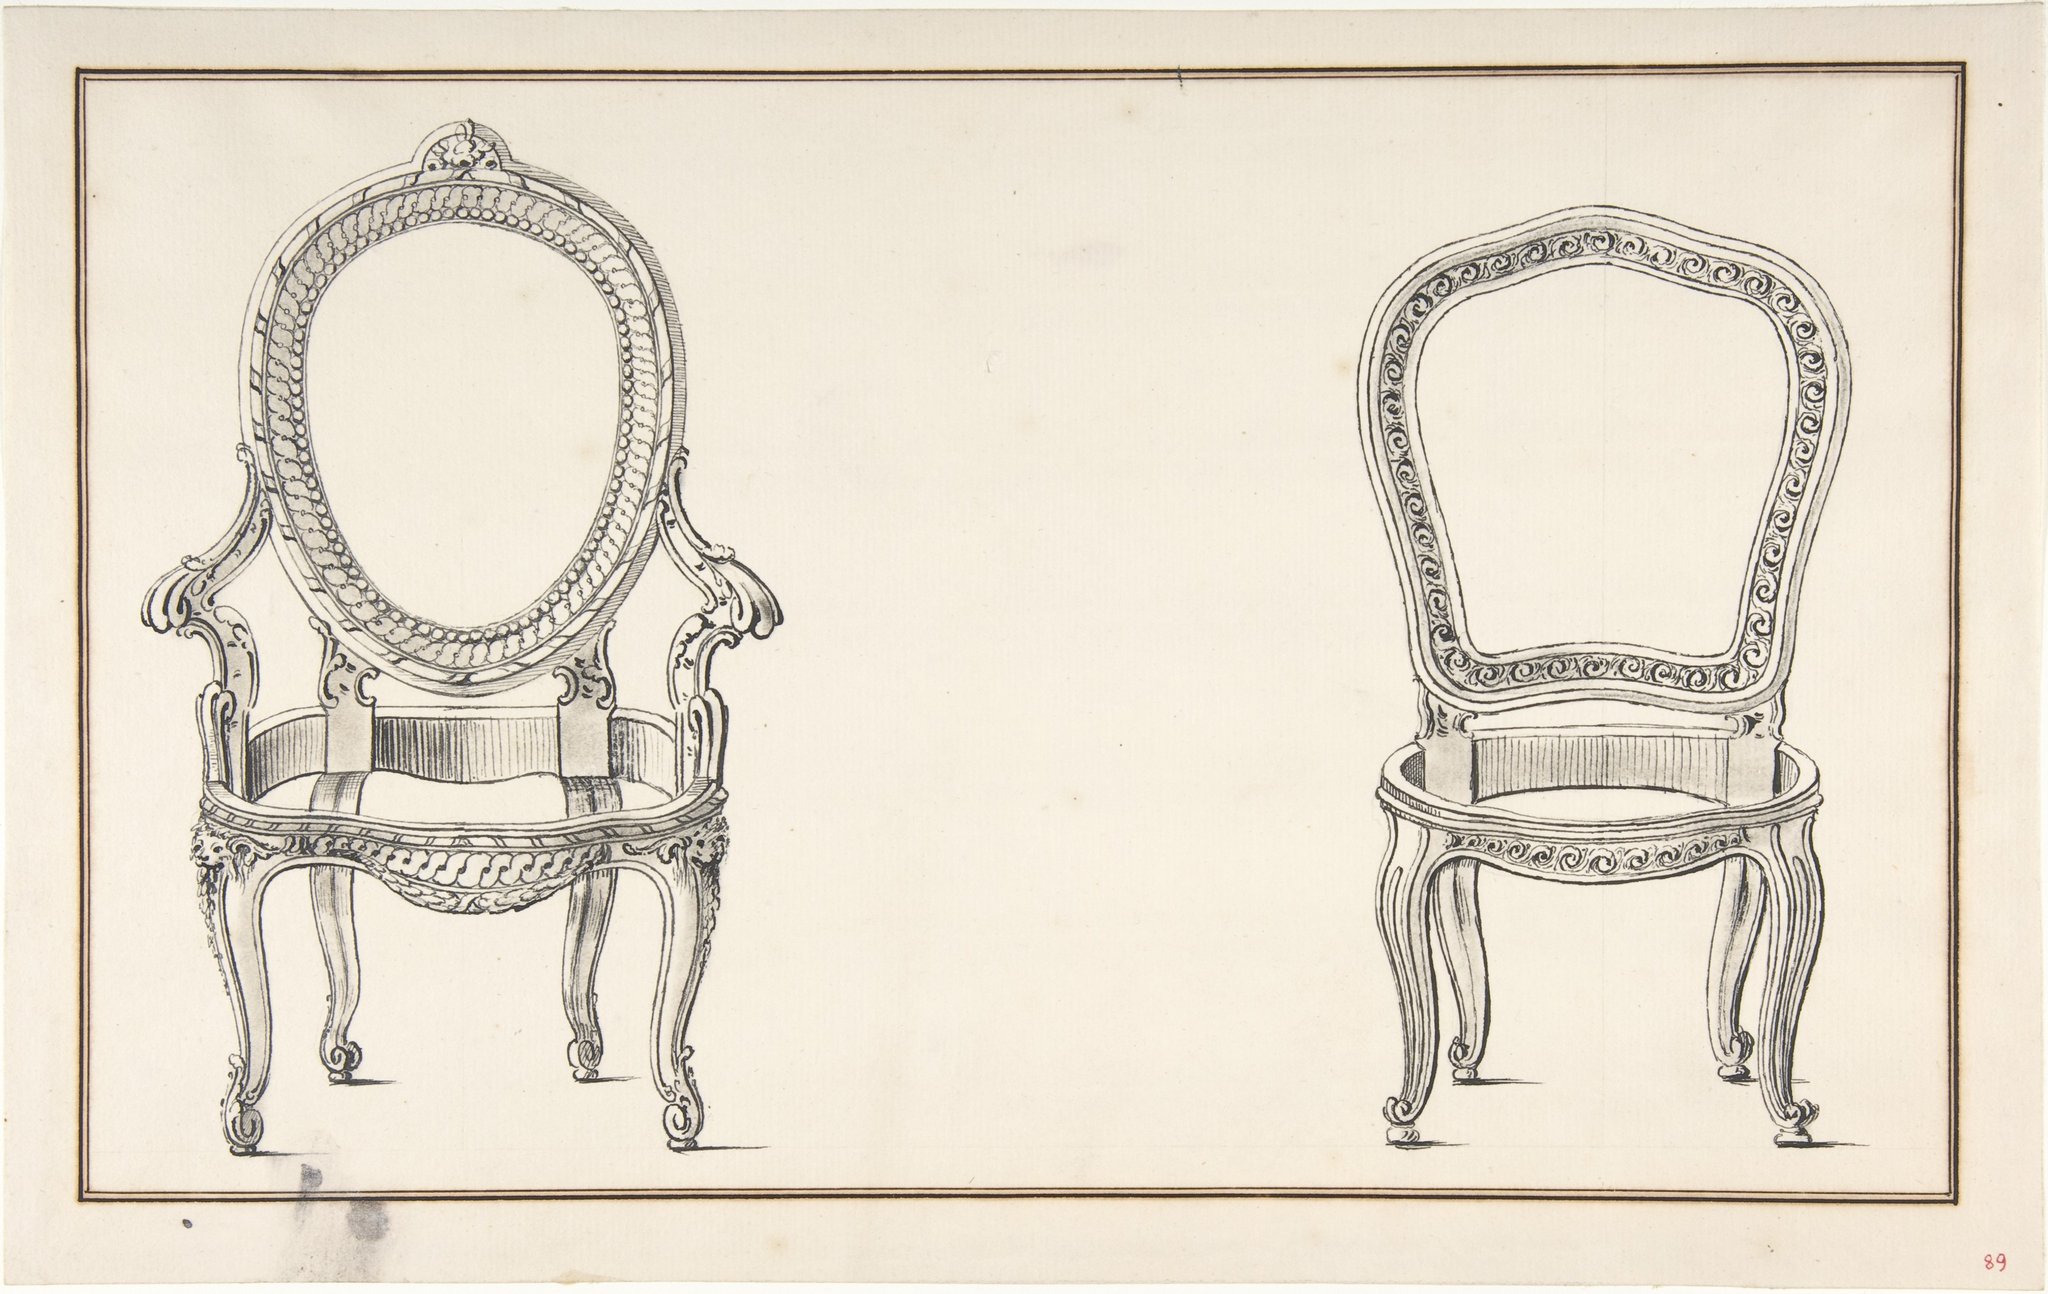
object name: drawing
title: Design for Two Chairs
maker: anonymous, french, 18th century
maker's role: artist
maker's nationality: french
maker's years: 1700-1800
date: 1770-1790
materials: graphite, ink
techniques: brush, pen, wash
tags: chairs